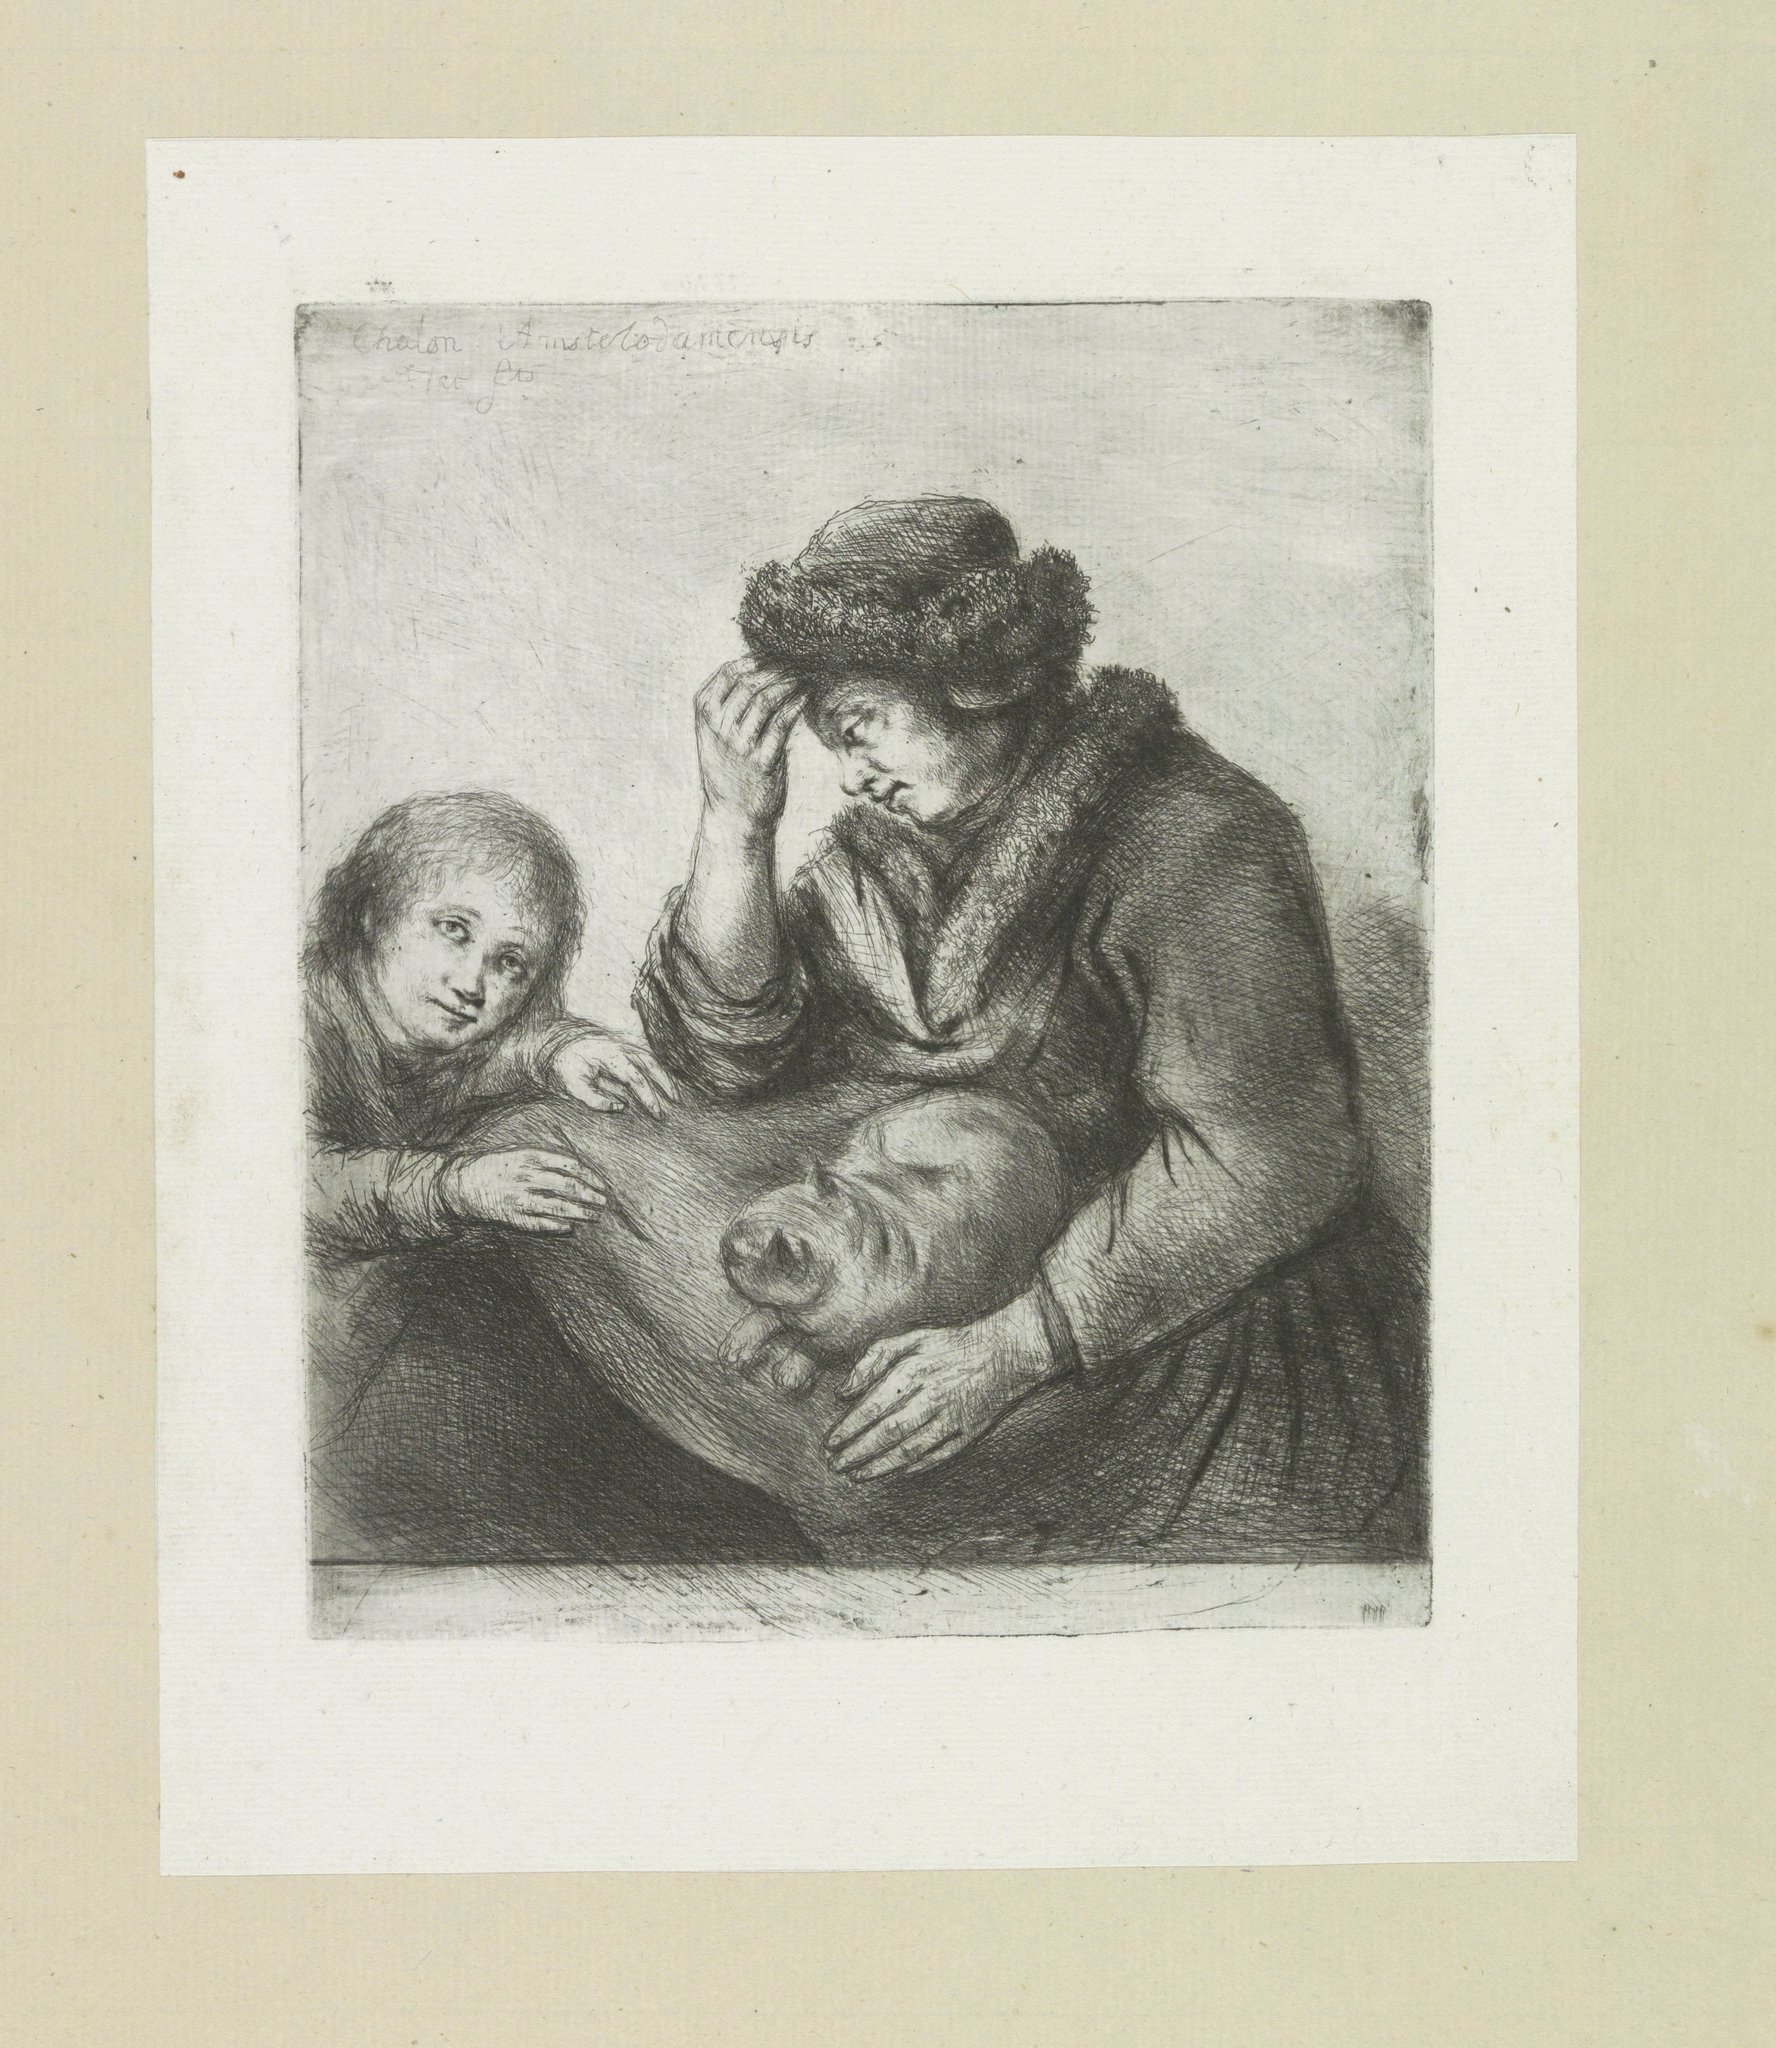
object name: print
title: Moeder met kind en kat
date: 1802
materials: paper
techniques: drypoint, etching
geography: london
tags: cat, boy (child between toddler and youth), morphology of human expression (+ adult female (human being))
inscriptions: collector's mark: ‘B’, collector's mark: ‘RIJKS / MUSM’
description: Een moeder met een kind. Haar kind speelt met een kat die op haar knieën ligt. De prent maakt deel uit van een album.